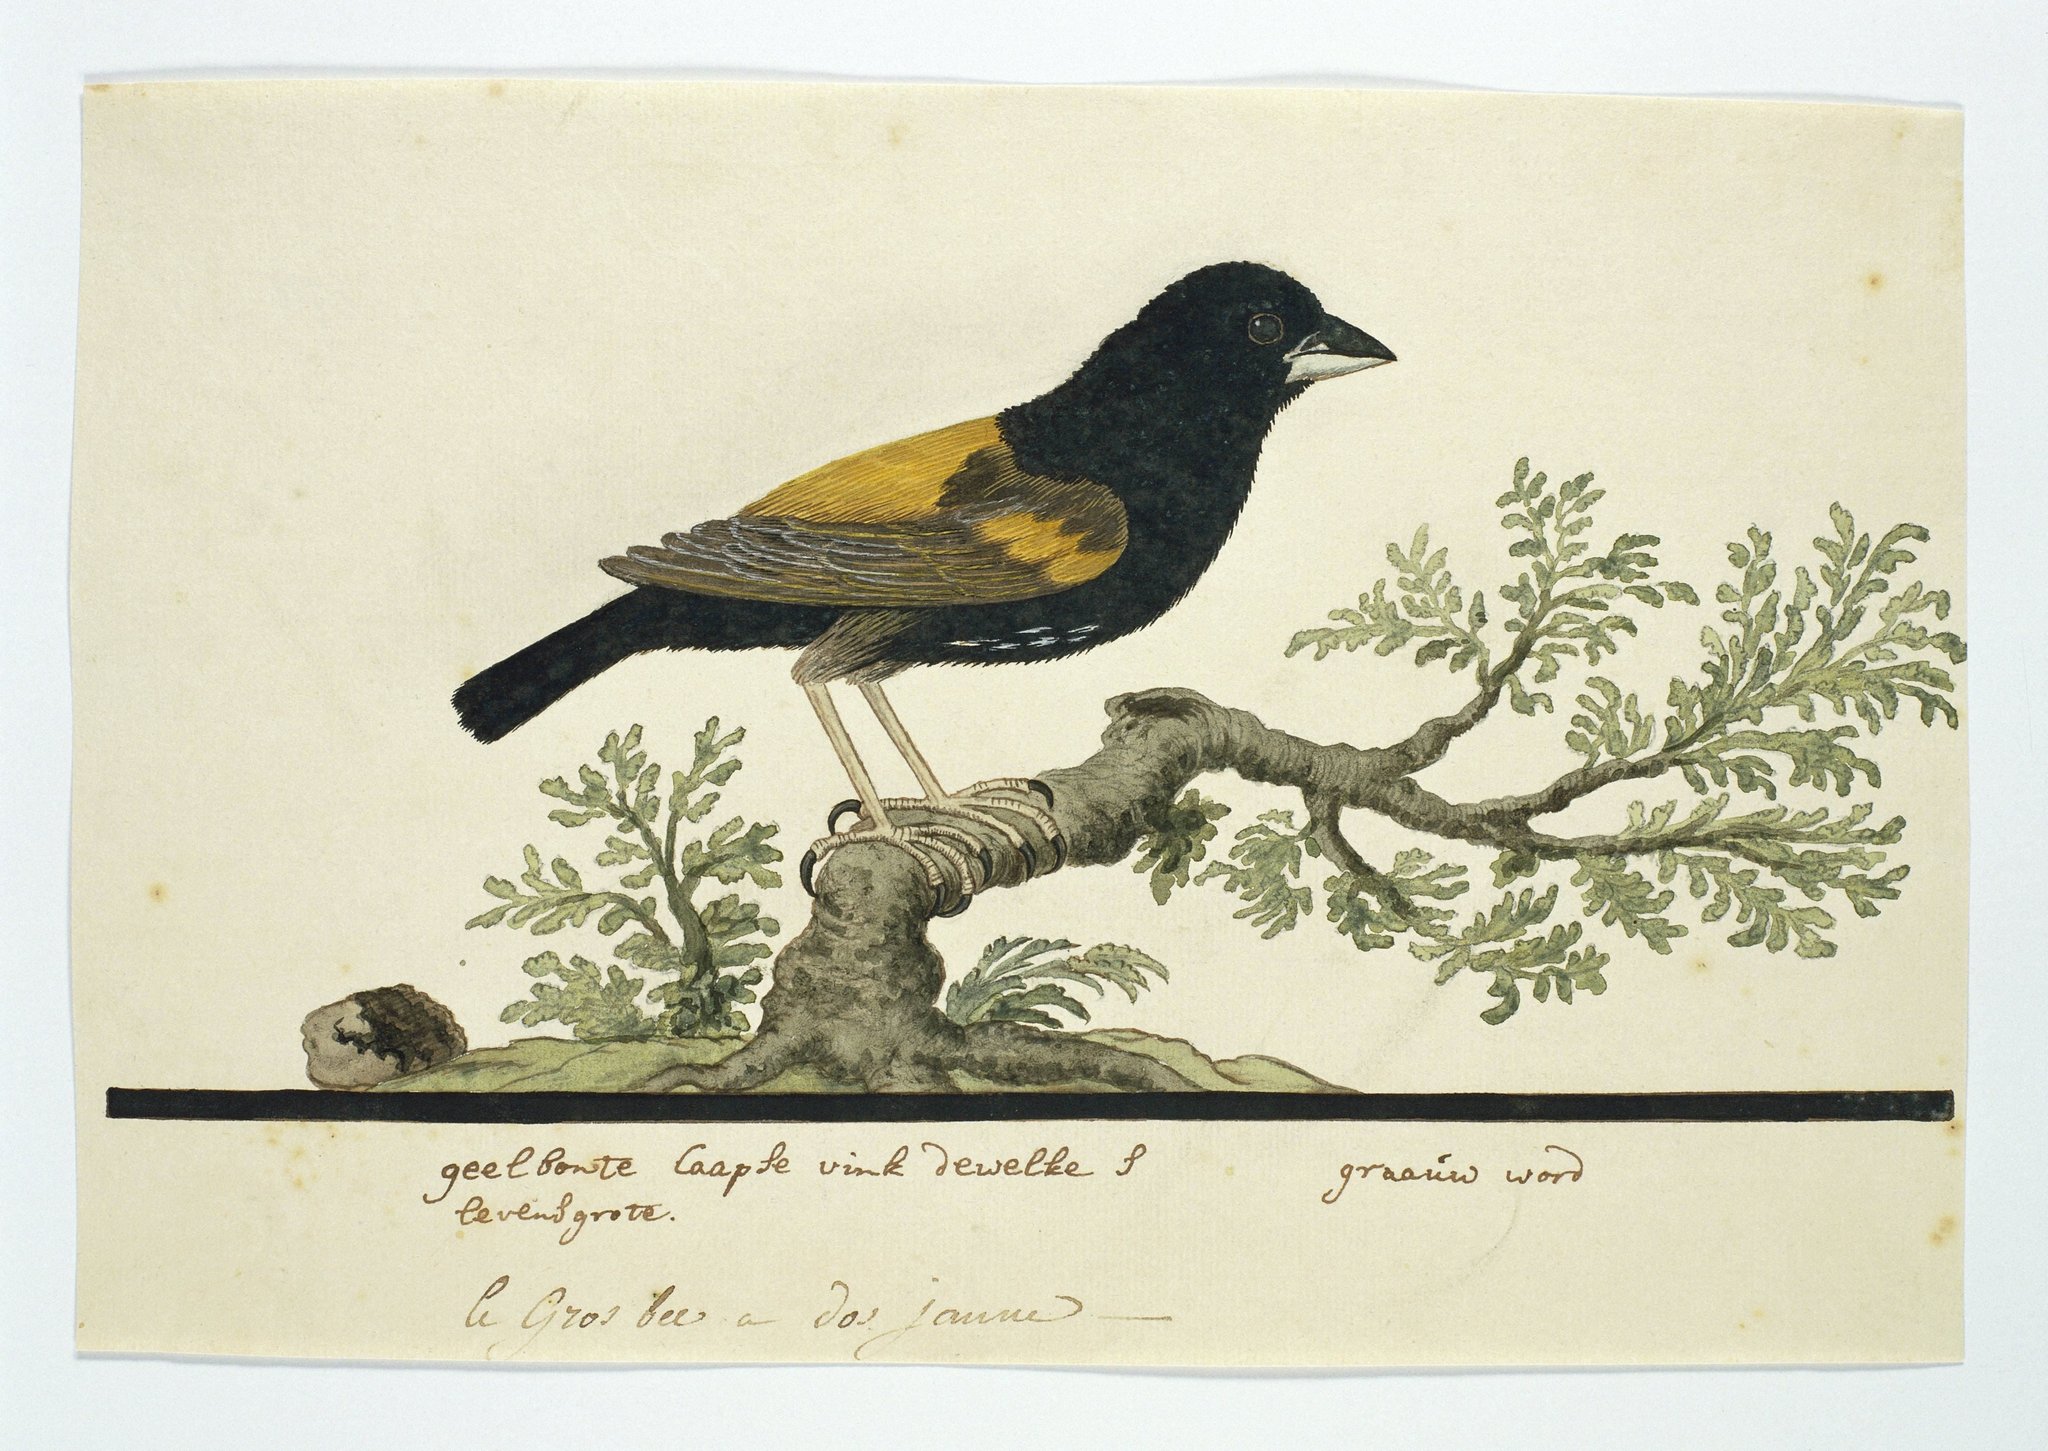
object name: album leaf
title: Euplectes capensis (Yellow bishop)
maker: robert jacob gordon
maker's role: draughtsman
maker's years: 1743-1795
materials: paint, ink, paper, pencil, watercolor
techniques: brush, pen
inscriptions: annotation: ‘geelbonte Caapse vink dewelke S [leeg] graauw word. / levensgrote/ le Gros bec en dos jaune.’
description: Yellow-rumped widow (Eng.). Franse benaming geschreven door Levaillant.